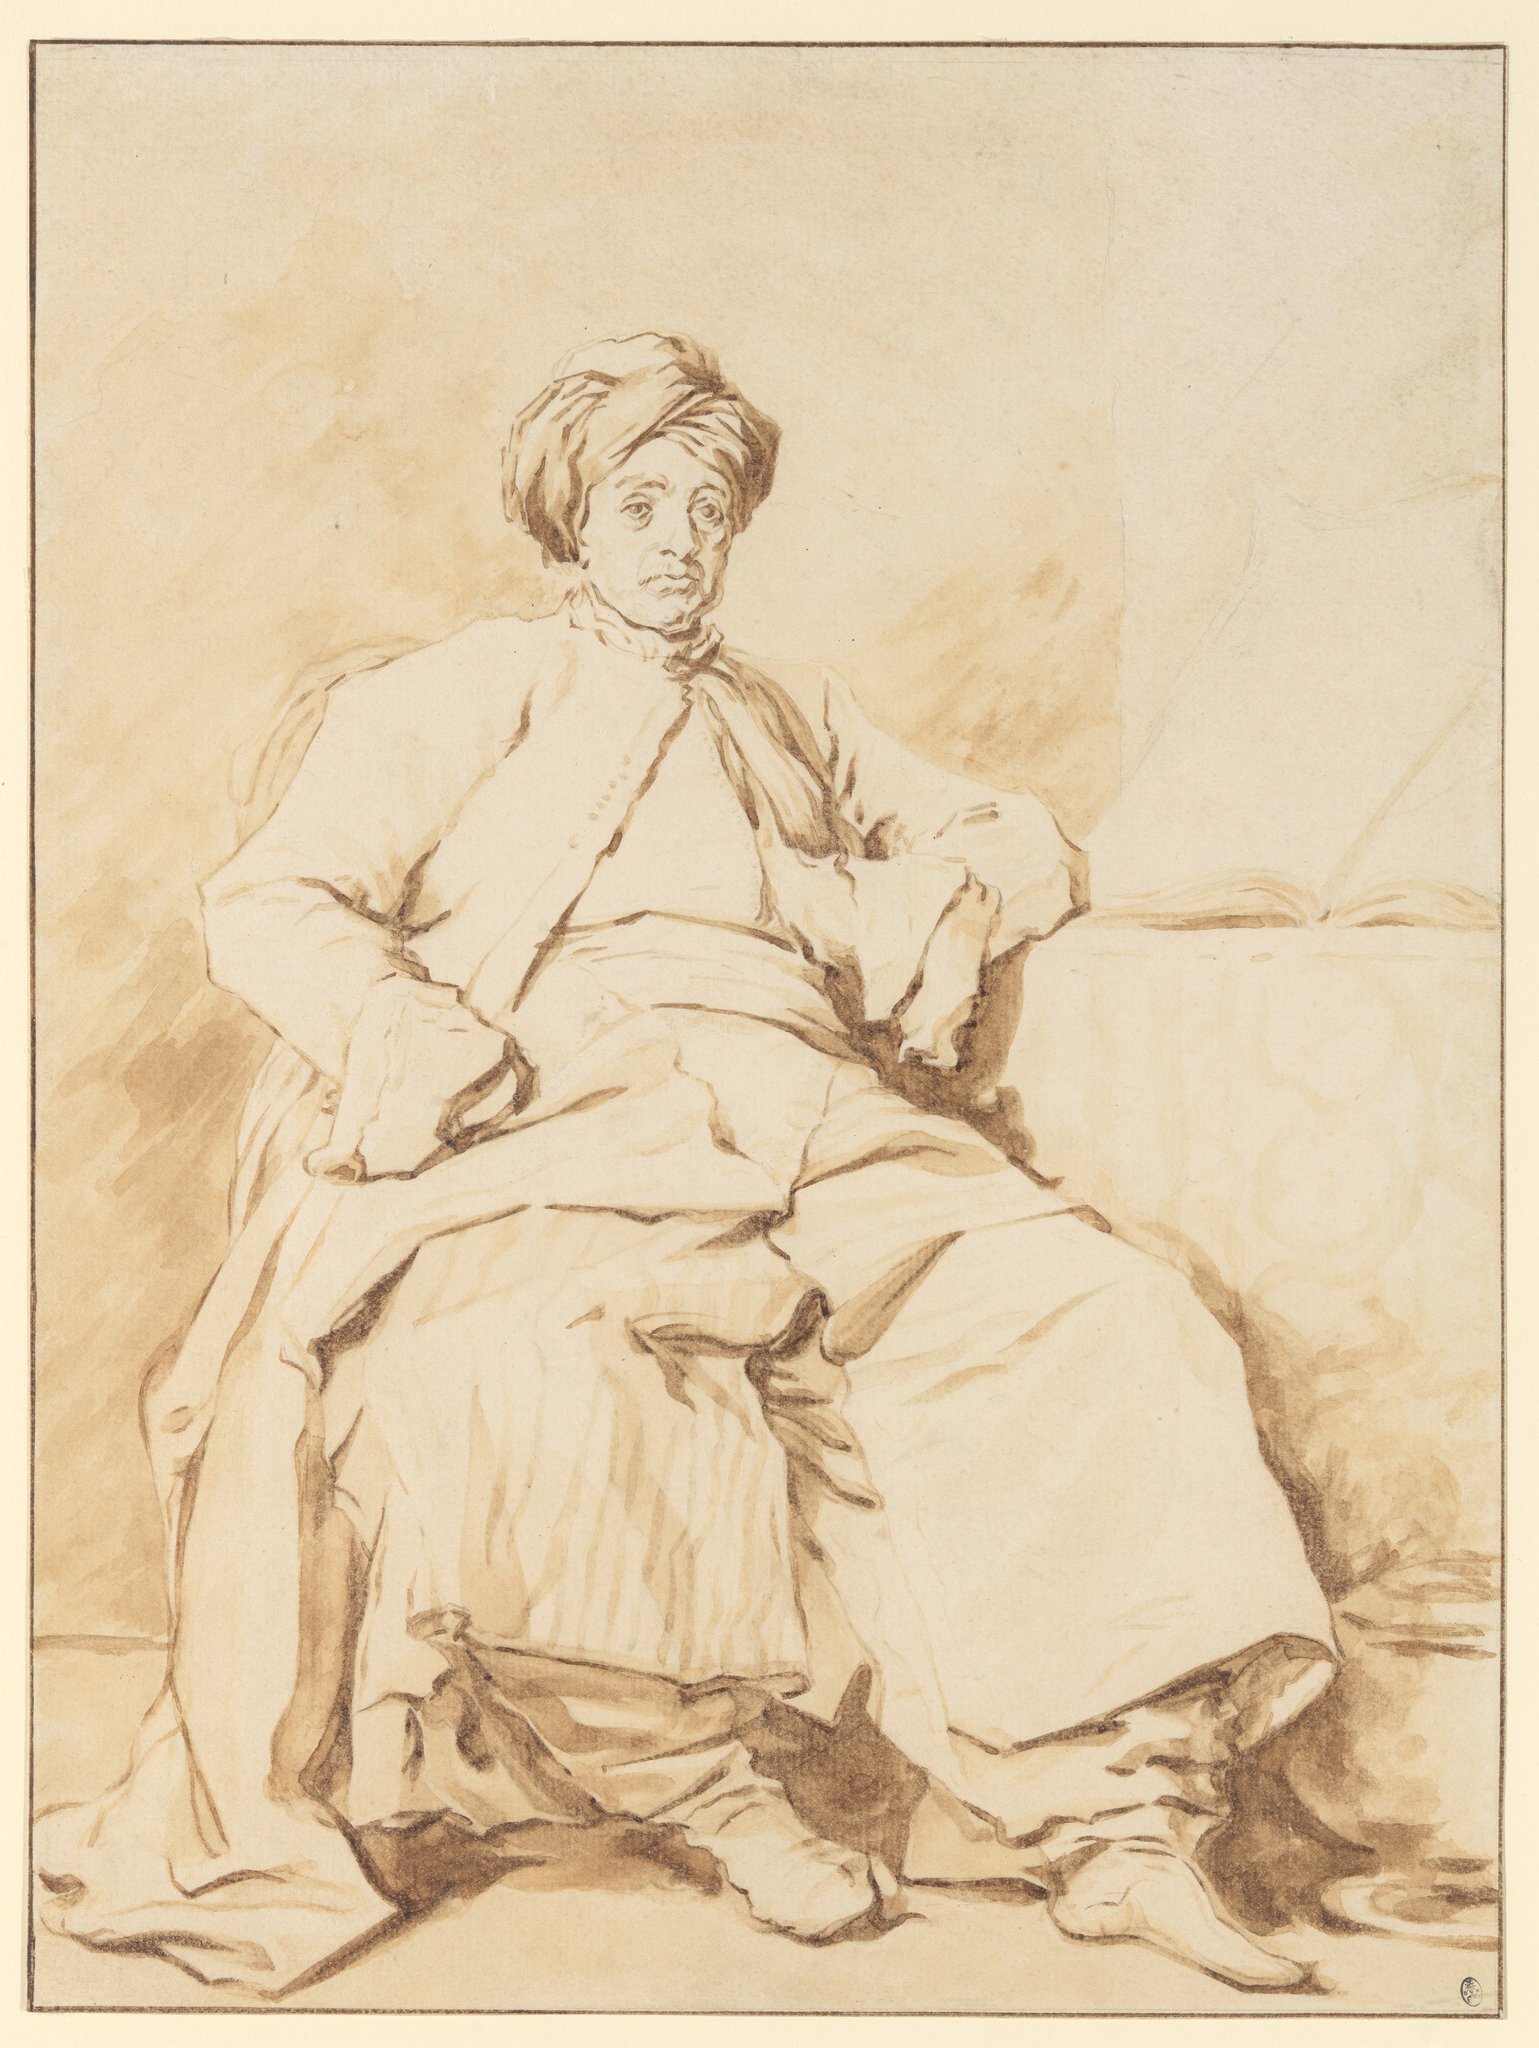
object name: drawing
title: The Sultan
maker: jean honoré fragonard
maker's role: artist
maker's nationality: french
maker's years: 1732-1806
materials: graphite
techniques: brush, wash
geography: france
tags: men